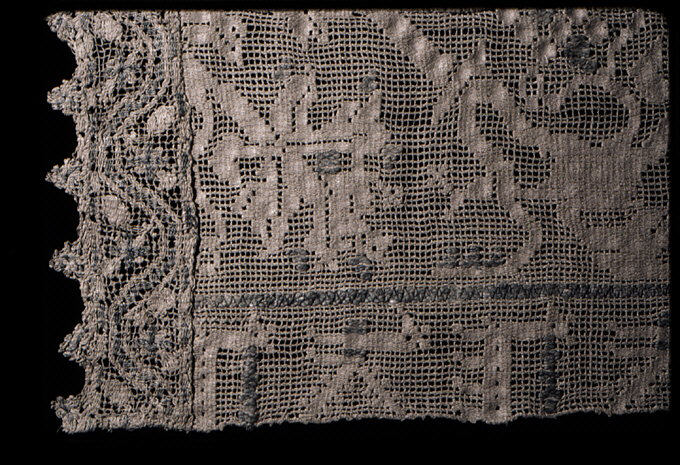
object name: border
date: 1501-1600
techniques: embroidery